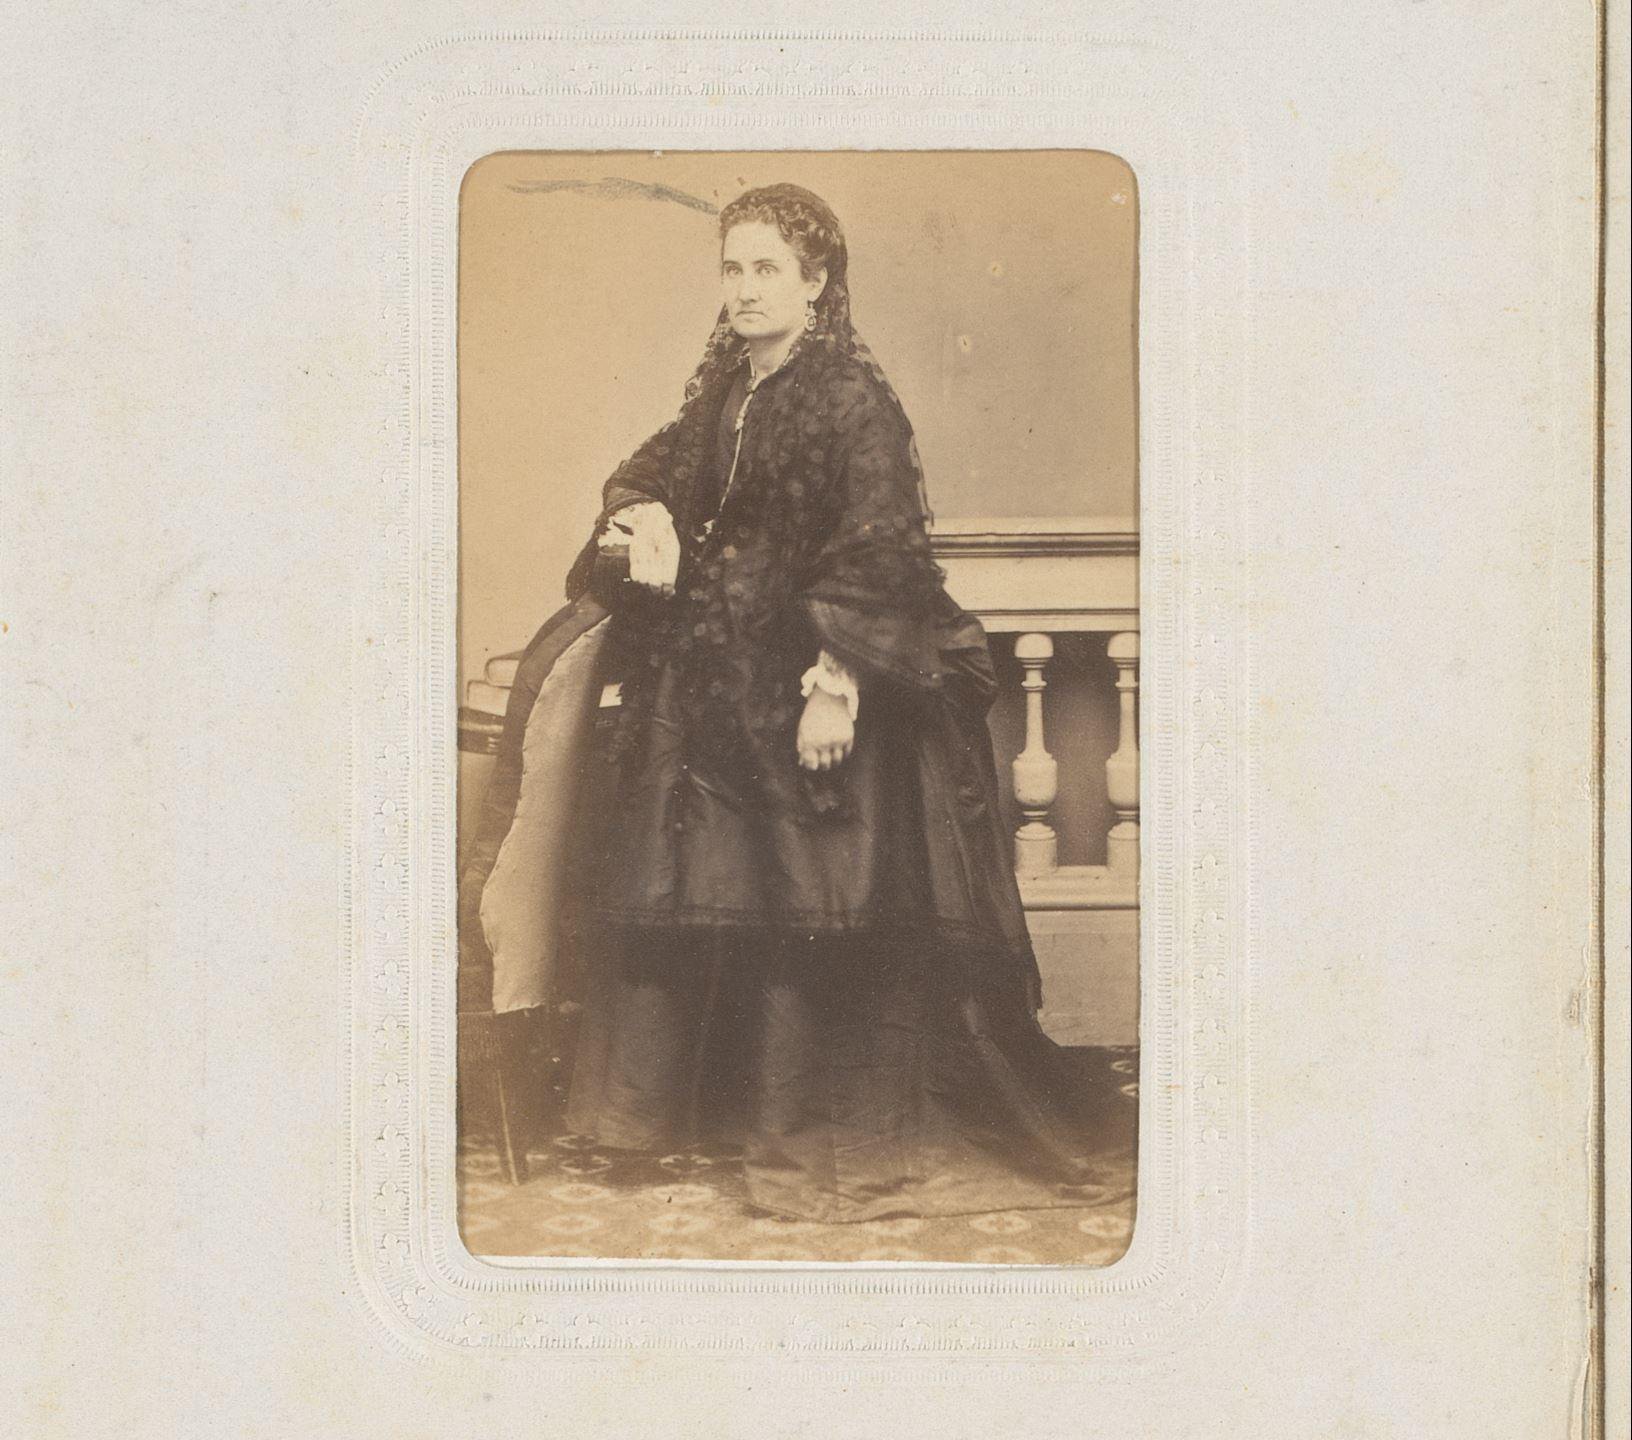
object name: album leaf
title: Portret van een vrouw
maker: Anonymous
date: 1860-1890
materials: cardboard, photographic support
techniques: albumen print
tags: historical persons - bb - woman